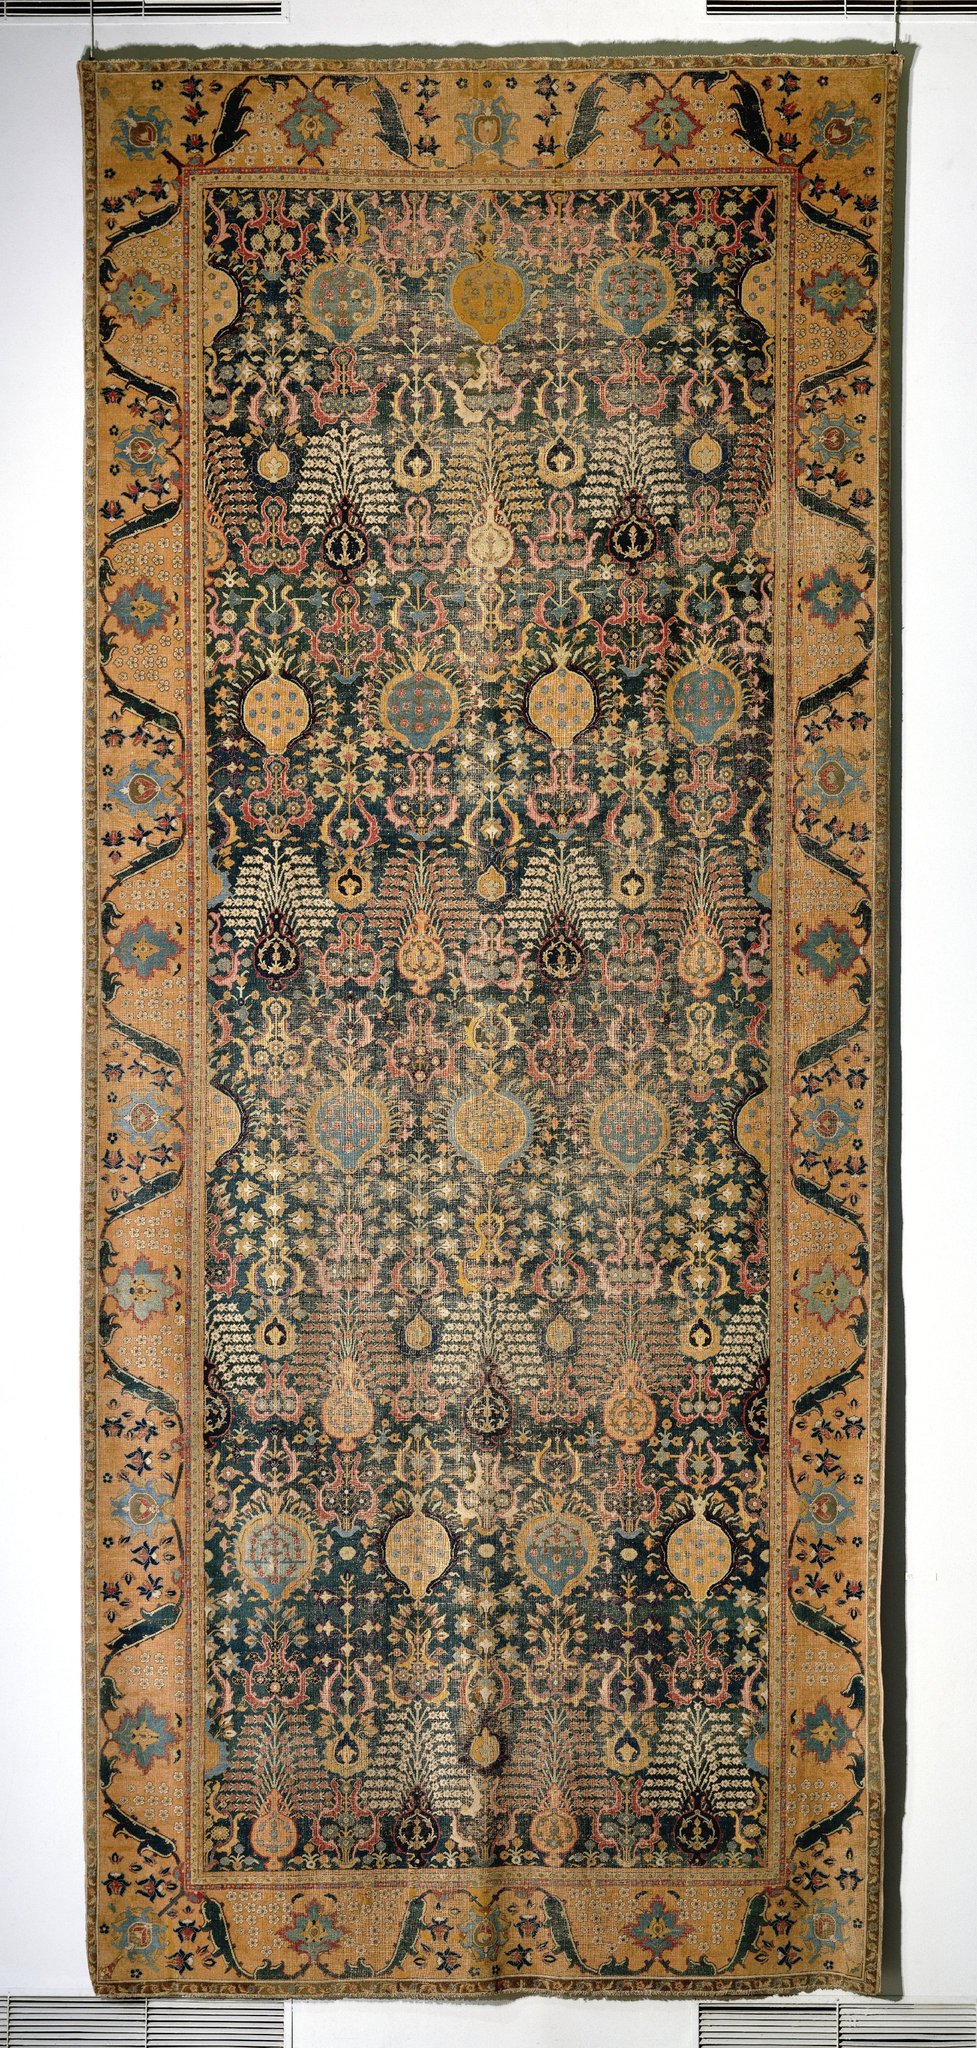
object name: tapijt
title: Oosters tapijt, zogenaamd 'vazentapijt'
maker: Anonymous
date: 1600-1650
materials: cotton, wool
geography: south persia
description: Oosters tapijt, bloemen- en vazenkleed, waarvan het middenveld versierd is met candelaber-motieven opgebouwd uit vazen en arabesken.